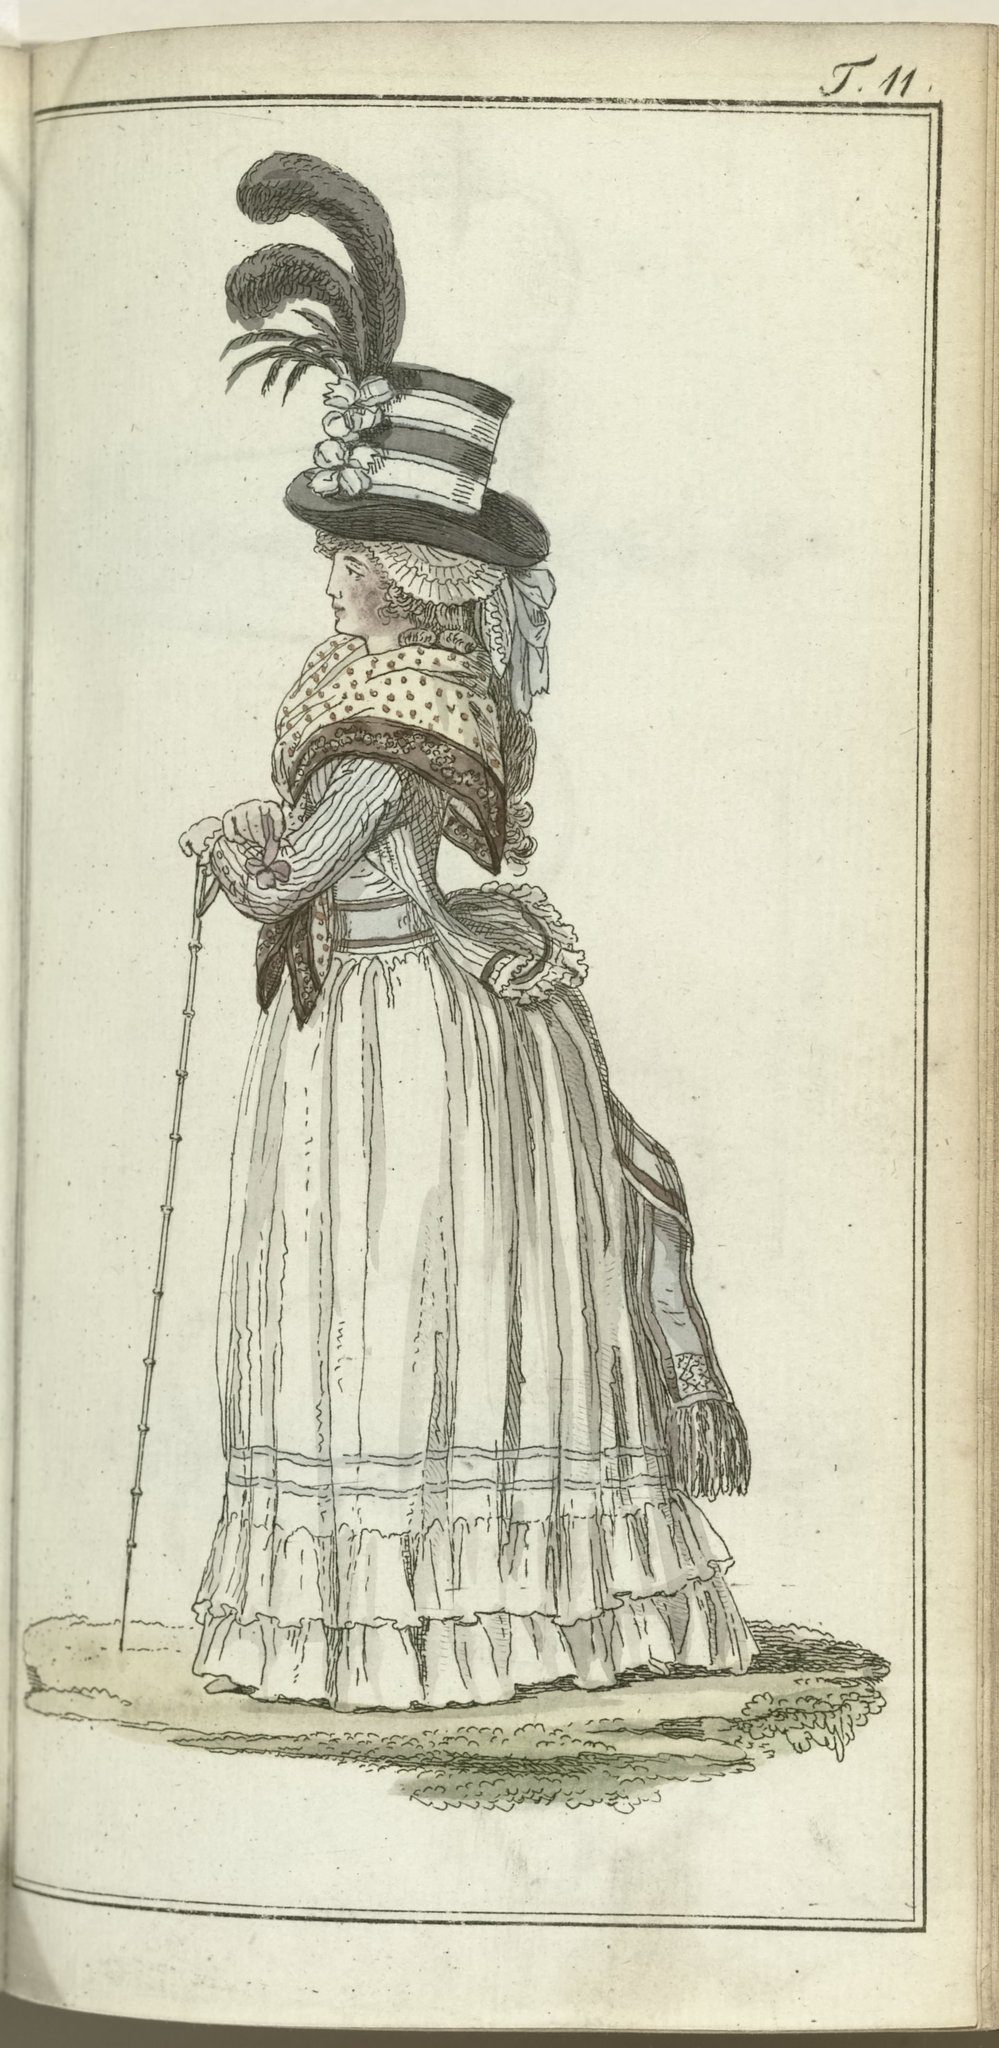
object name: magazine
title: Journal des Luxus und der Moden 1790, Band V, T.11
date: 1790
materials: paper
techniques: etching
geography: weimar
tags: fashion plates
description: Prent uit het modetijdschrift Journal des Luxus und der Moden, uitgegeven door Friedrich Justin Bertuch en Georg Melchior Kraus, Weimar, 1786-1826.